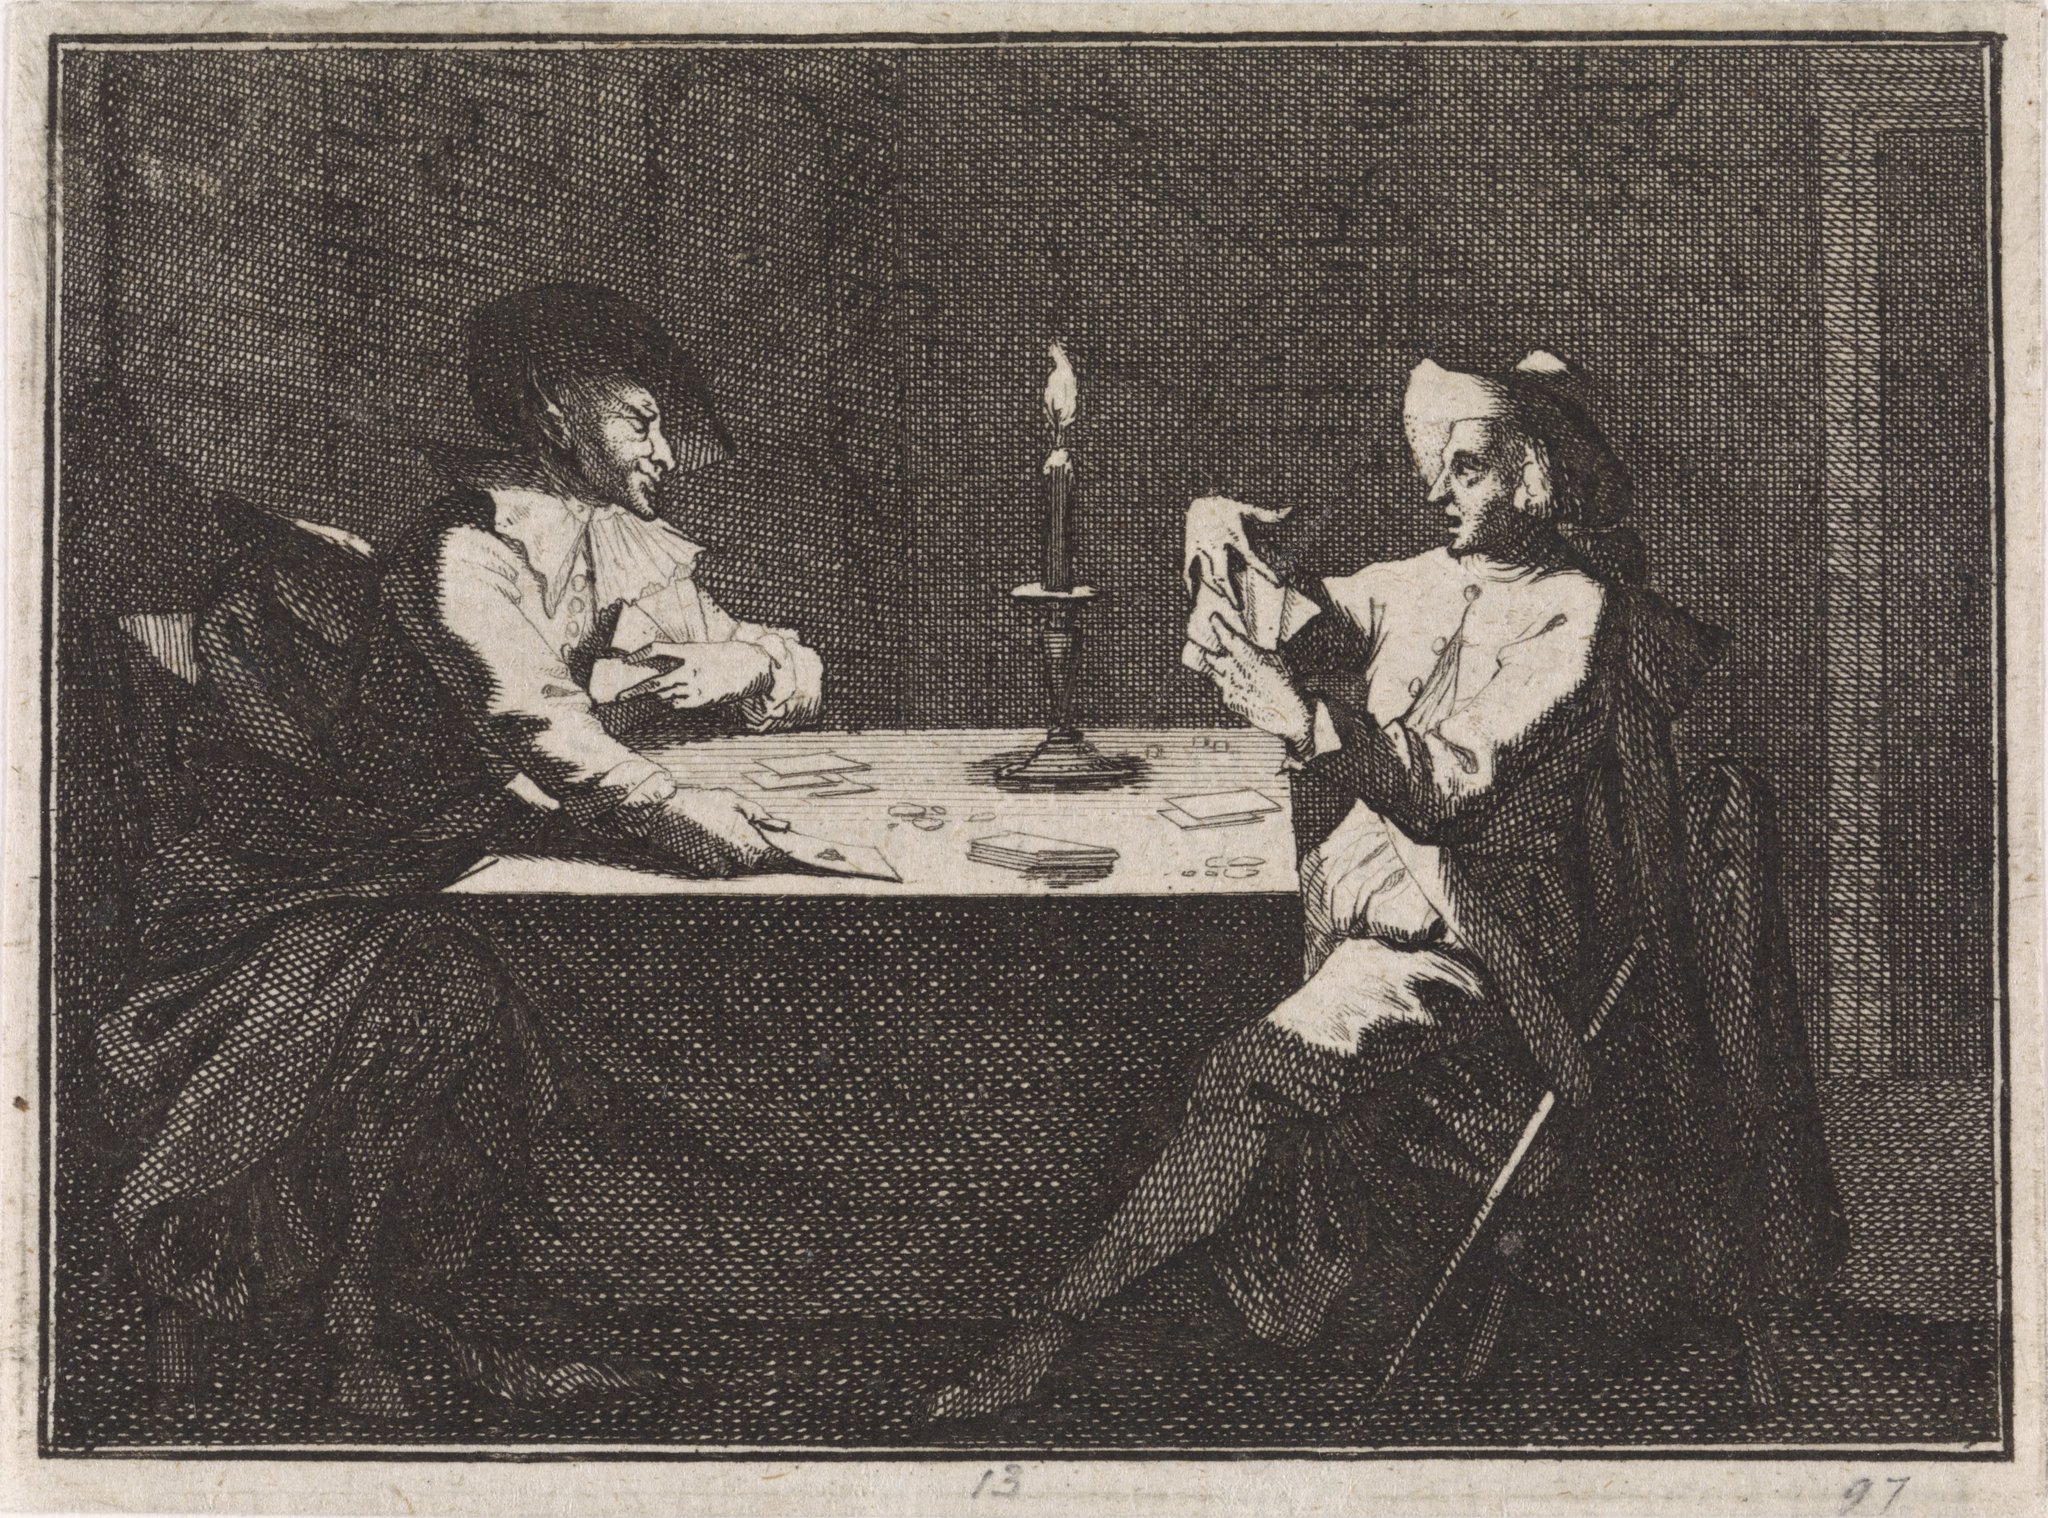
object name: print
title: Du Teufels-Papier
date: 1704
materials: paper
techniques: etching, letterpress printing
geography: nuremberg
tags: playing-cards, devil(s) appearing to mortals, trying to seduce them; temptation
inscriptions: collector's mark: Lugt 2228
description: Illustratie uit: Abraham a Sancta Clara. Heilsames Gemisch Gemasch, das ist: Allerley seltsame und verwunderliche Geschichten (...). Neurenberg: Christoph Weigel, 1704, p. 97.